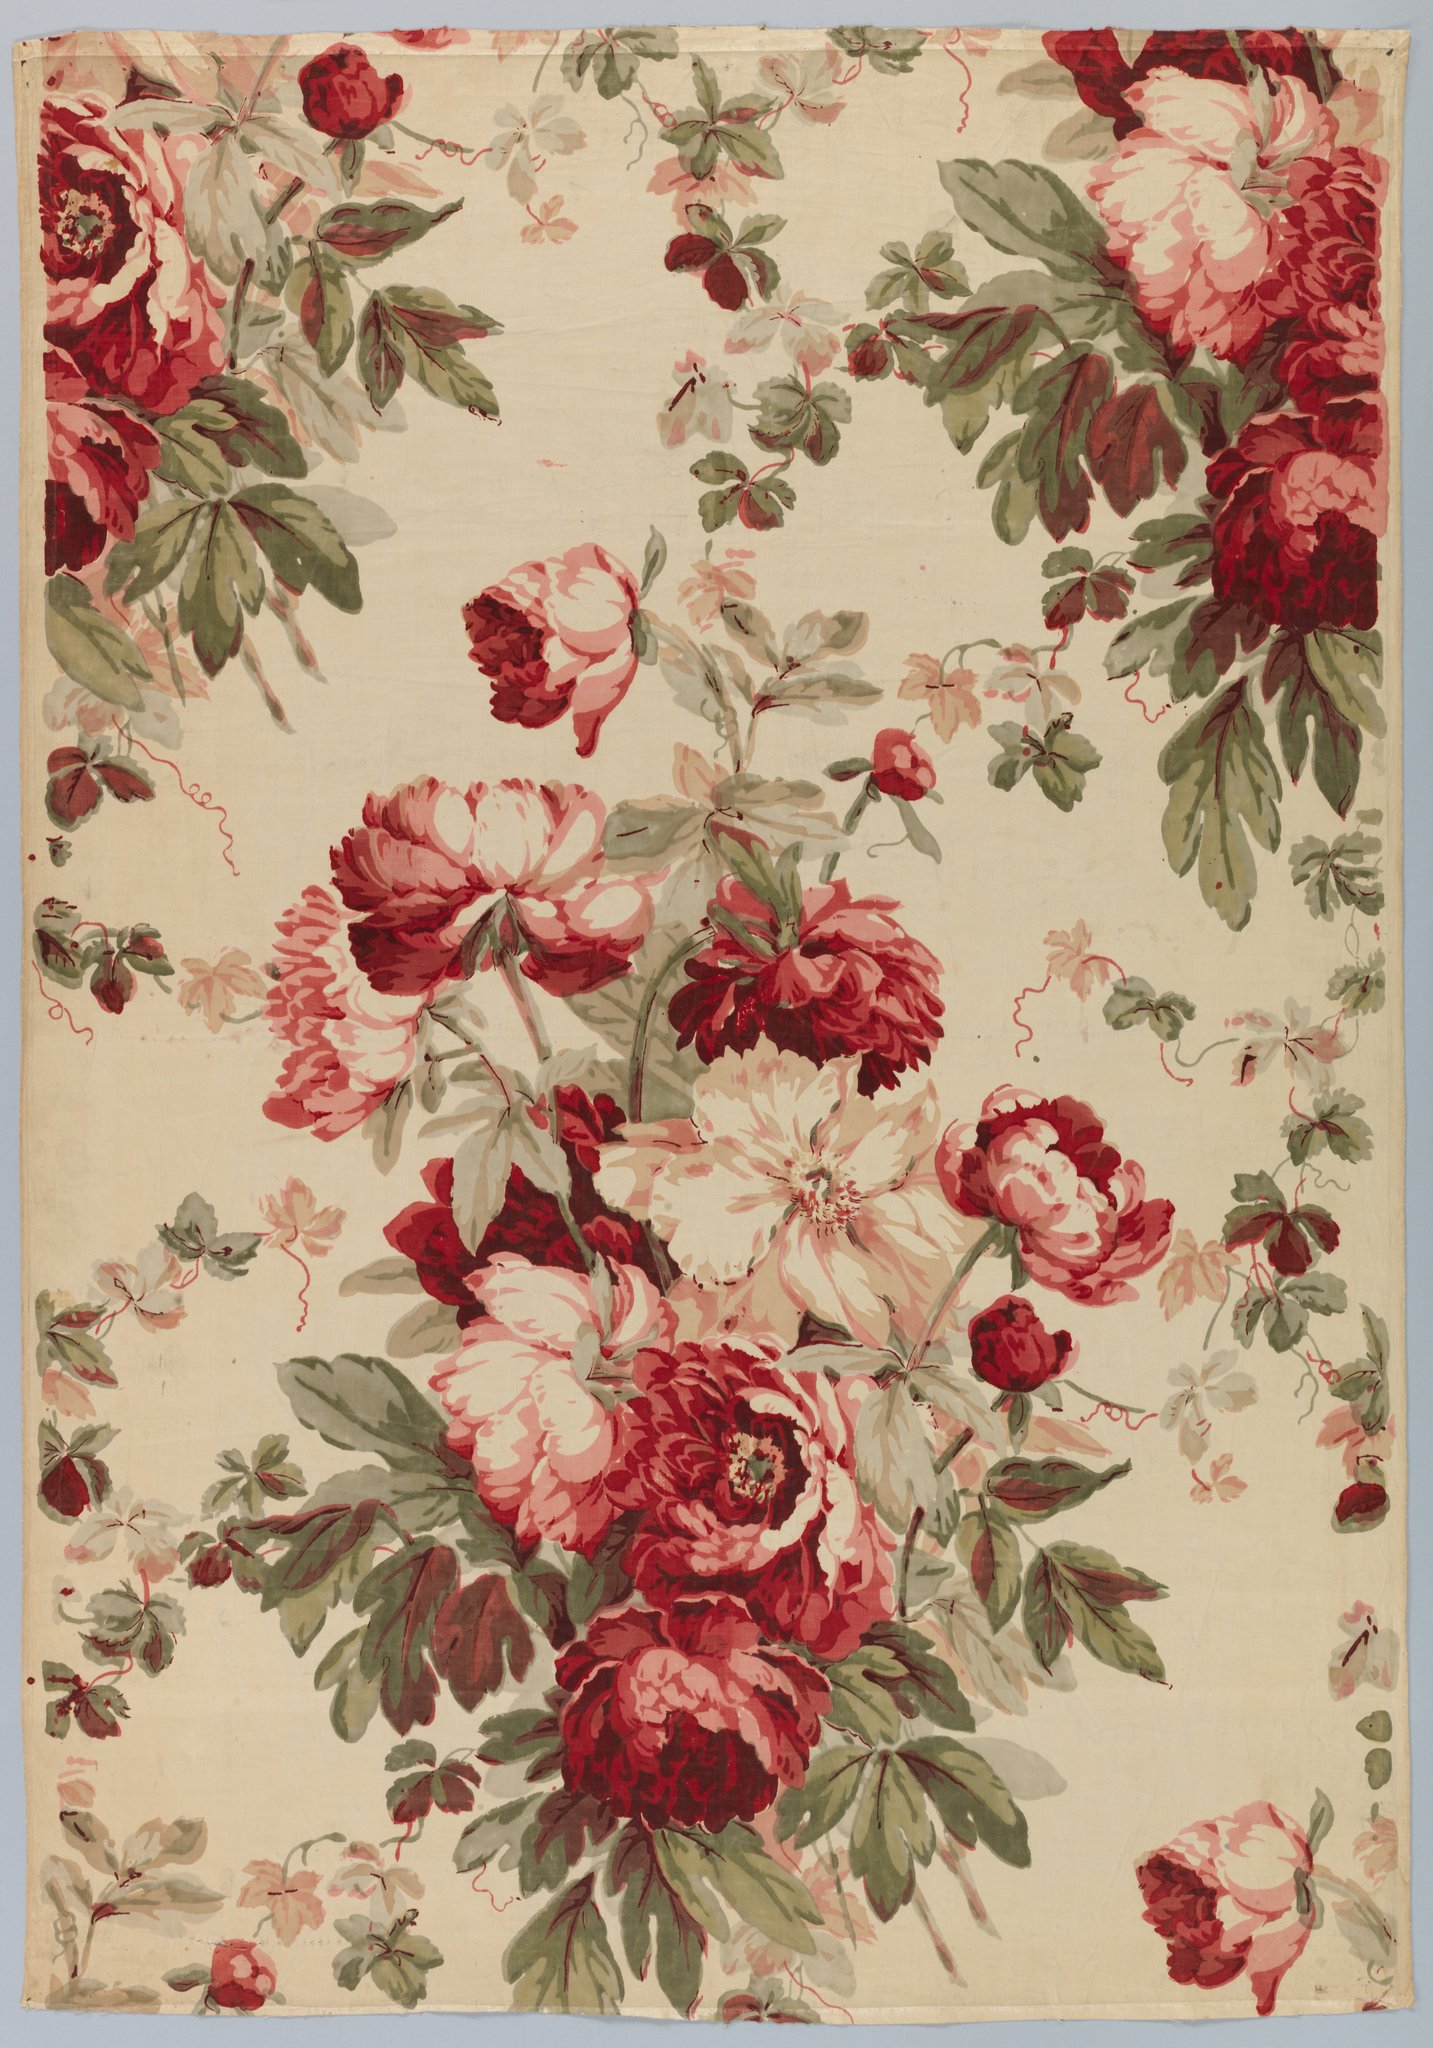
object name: piece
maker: dumont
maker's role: designer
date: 1872-1886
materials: cotton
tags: flowers,leaves